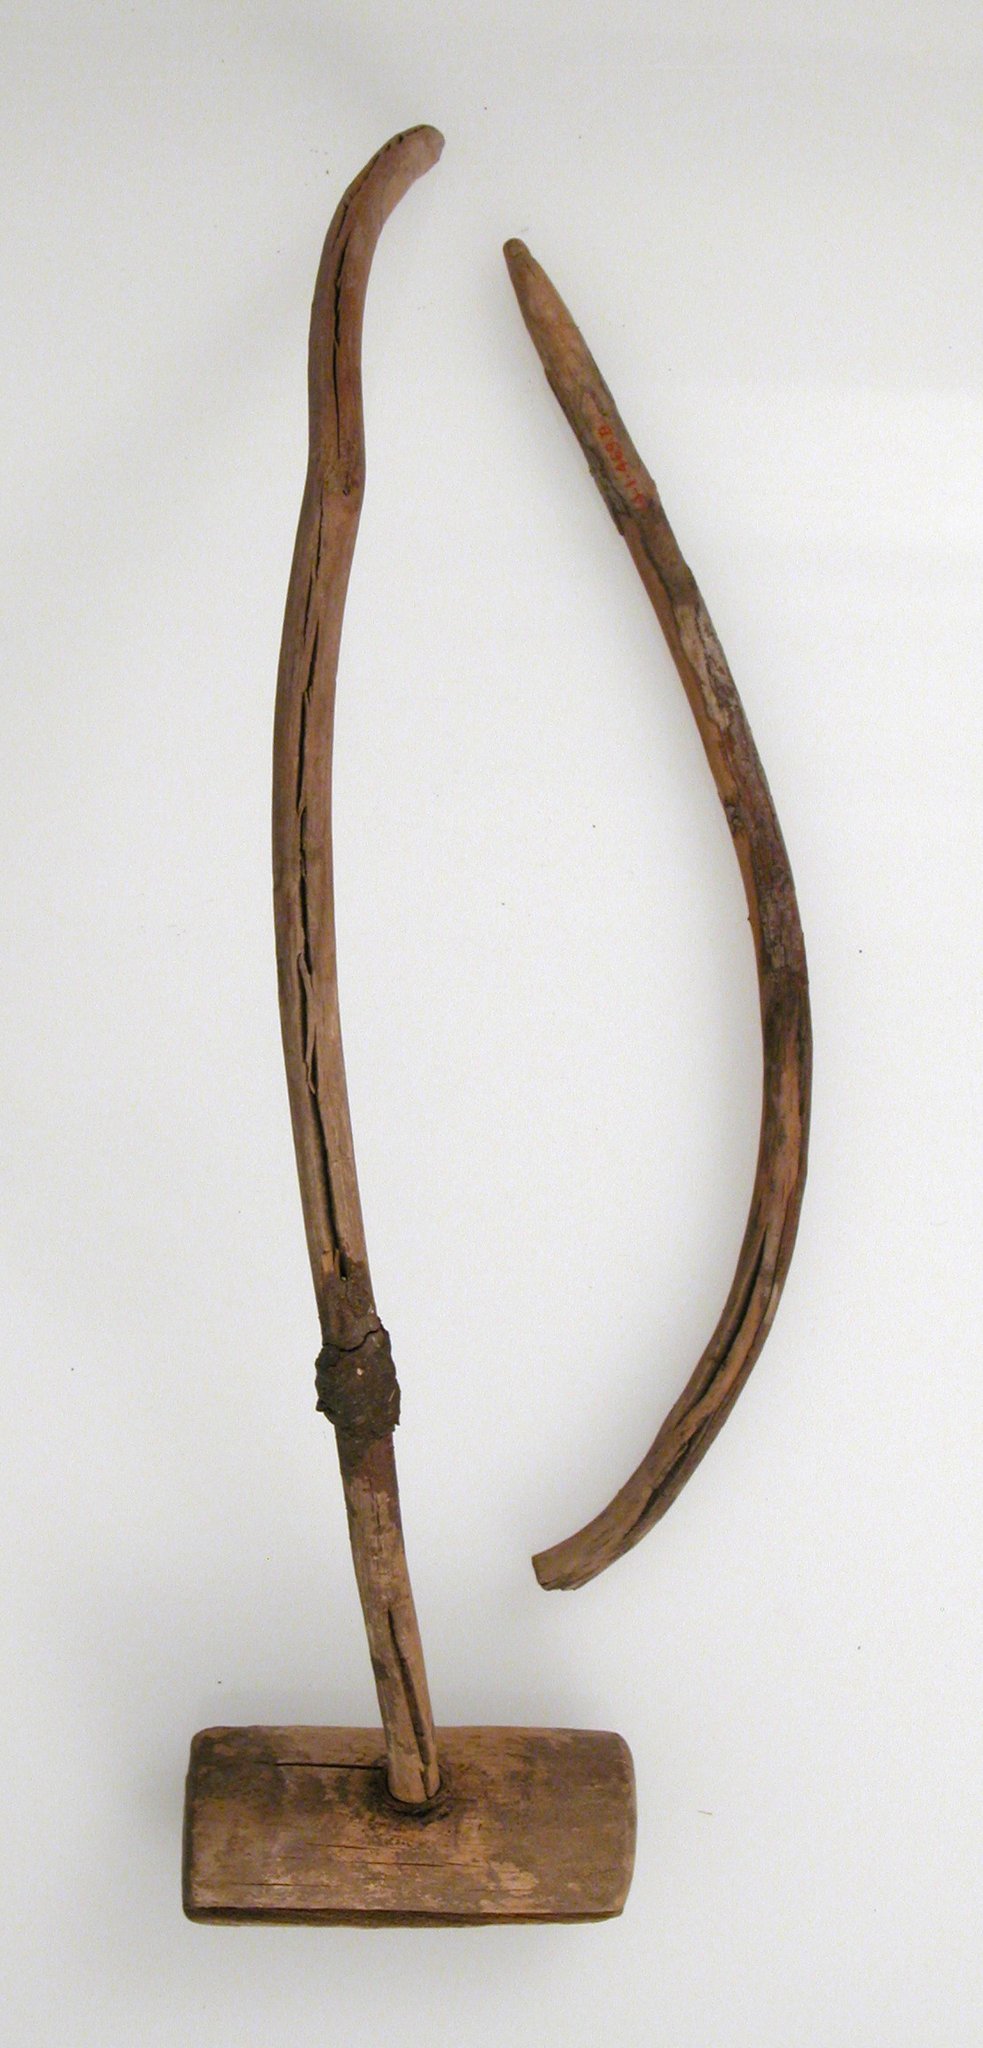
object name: fragment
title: Wood Fragments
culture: coptic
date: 580-640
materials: wood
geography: egypt